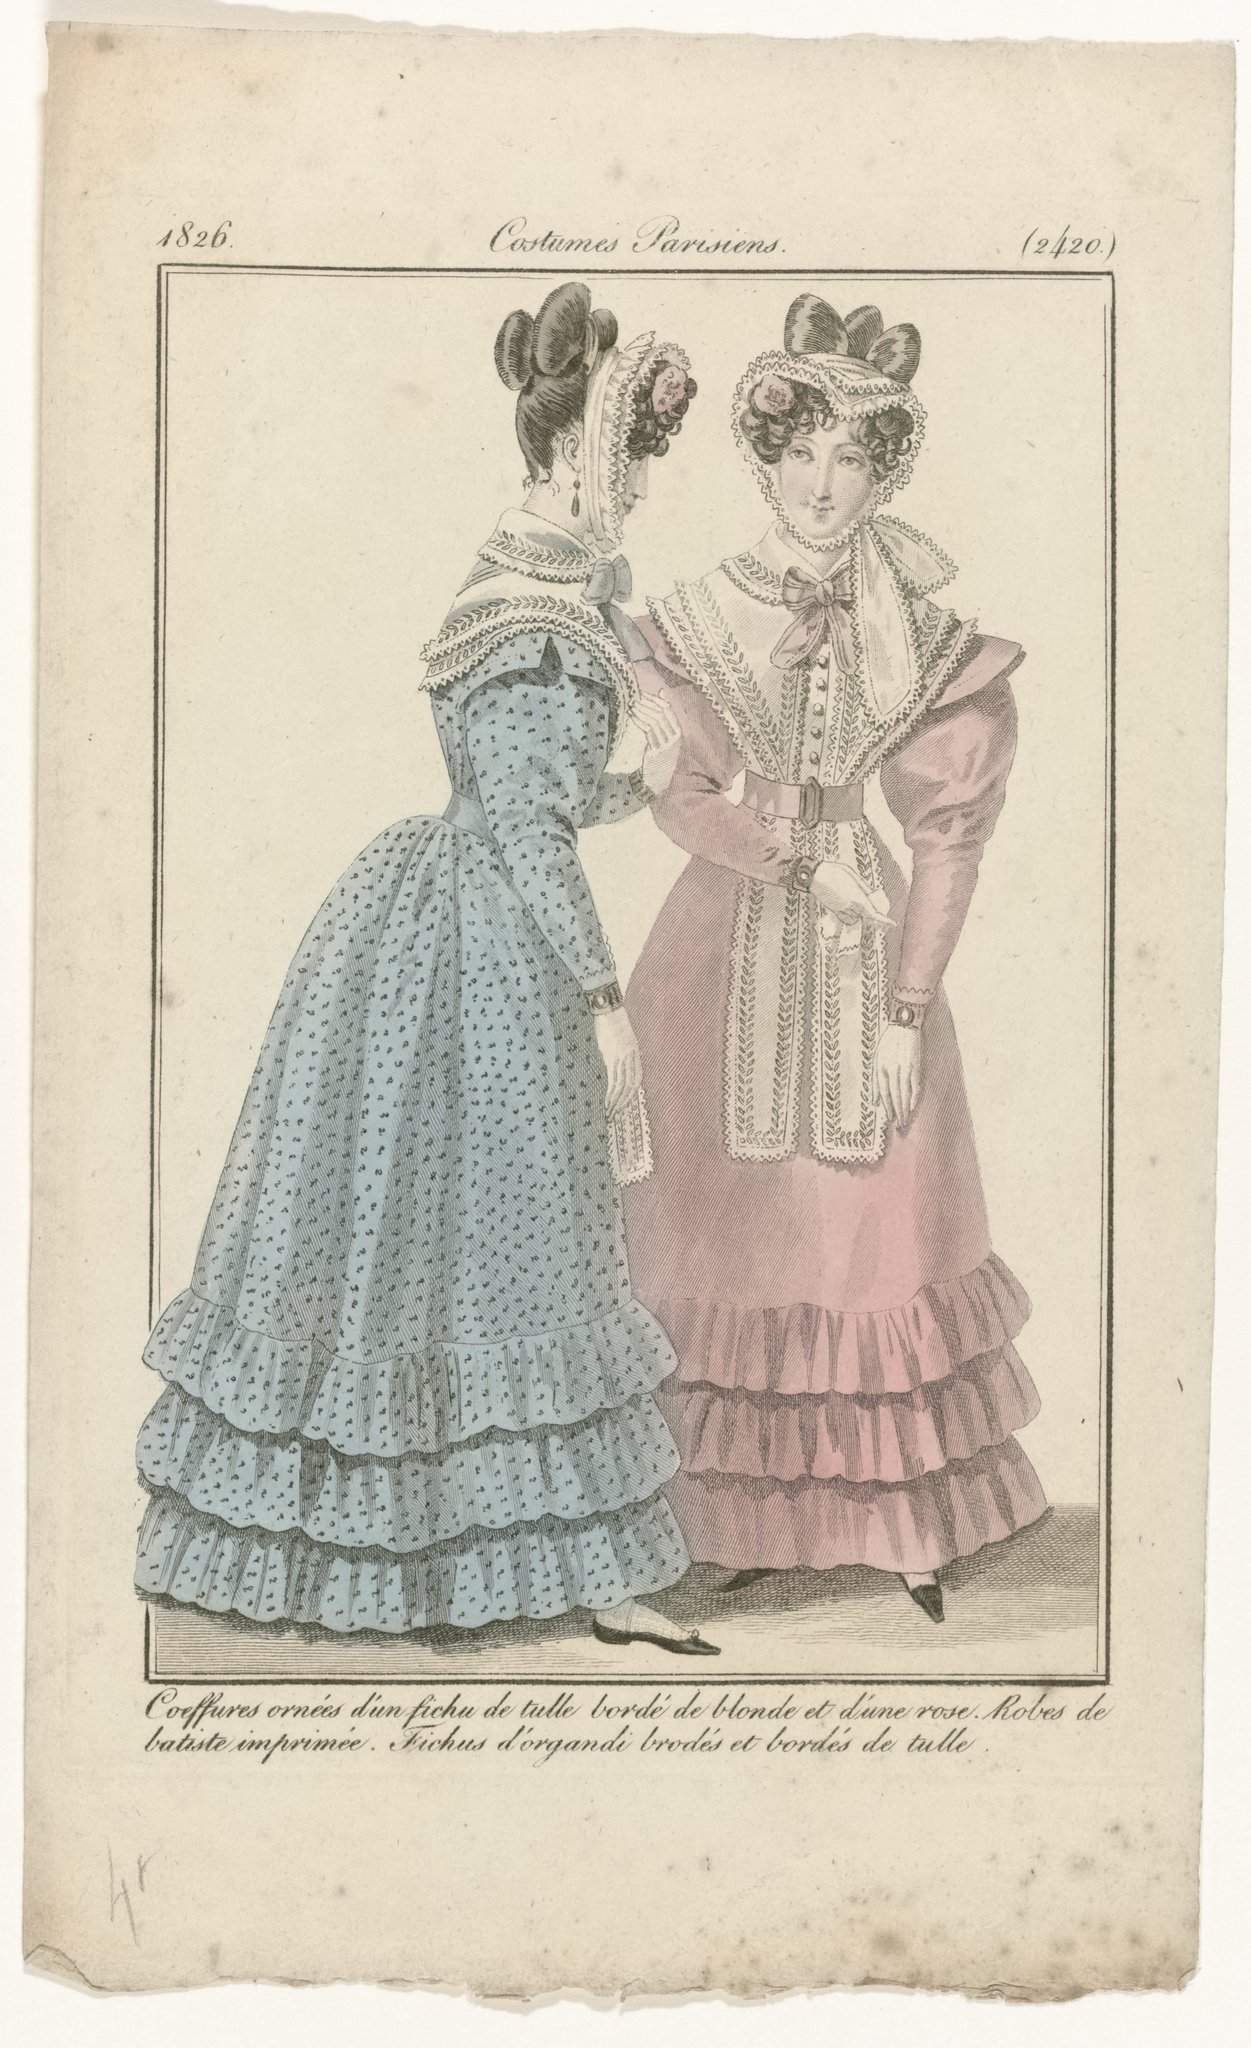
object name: fashion print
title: Journal des Dames et des Modes, Costumes Parisiens, 1826, (2420): Coeffures ornées d'un fichu (...)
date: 1826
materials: paper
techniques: engraving, hand coloring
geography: paris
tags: embroidery (ornamentation) (+ women's clothes), lace (+ women's clothes), styles of hairdress - aa - ~ women, fashion plates, dress, gown (+ women's clothes), flowers: rose, piece of clothing covering the breast or décolleté (fichu) (+ women's clothes), bracelet, wristlet (+ women's clothes)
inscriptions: caption: ‘Coeffures ornées d'un fichu de tulle bordé de blonde et d'une rose. Robes de batiste imprimée. Fichus d'organdi brodés et bordés de tulle.’, title: ‘Costumes Parisiens.’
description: De prent maakt deel uit van het modetijdschrift Journal des Dames et des Modes, uitgegeven door Pierre de la Mésangère, Parijs, 1797-1839.